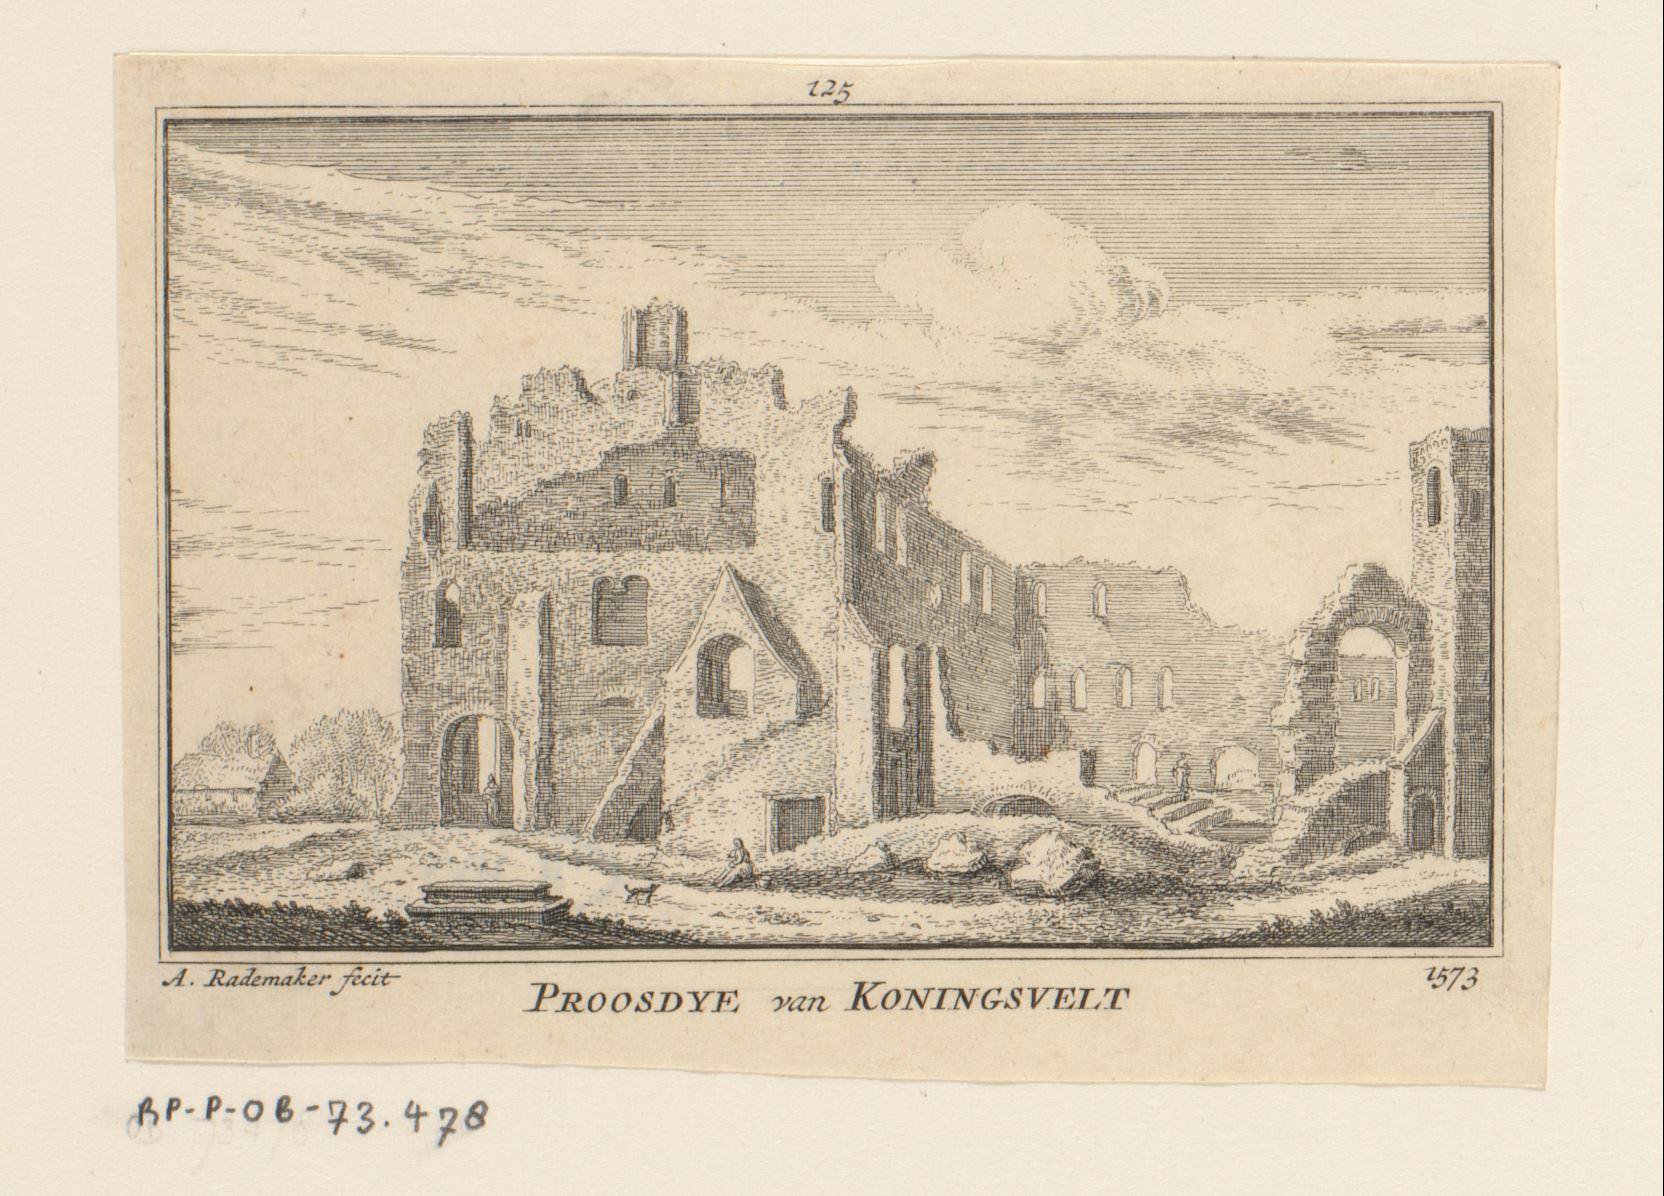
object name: book illustration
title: Proosdye van Koningsvelt 1573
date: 1727-1733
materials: paper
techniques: etching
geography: amsterdam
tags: ruin of church, monastery, etc.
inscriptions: collector's mark: Lugt 2228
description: Illustratie uit: Abraham Rademaker, Matthaeus Brouërius van Niedek, Isaac Le Long, Kabinet van Nederlandsche en Kleefsche outheden en (...) voorname stads- en landgebouwen, Willem Barents en Antoni Schoonenburg: Amsterdam, 1727-1733, ill. nr. 125.